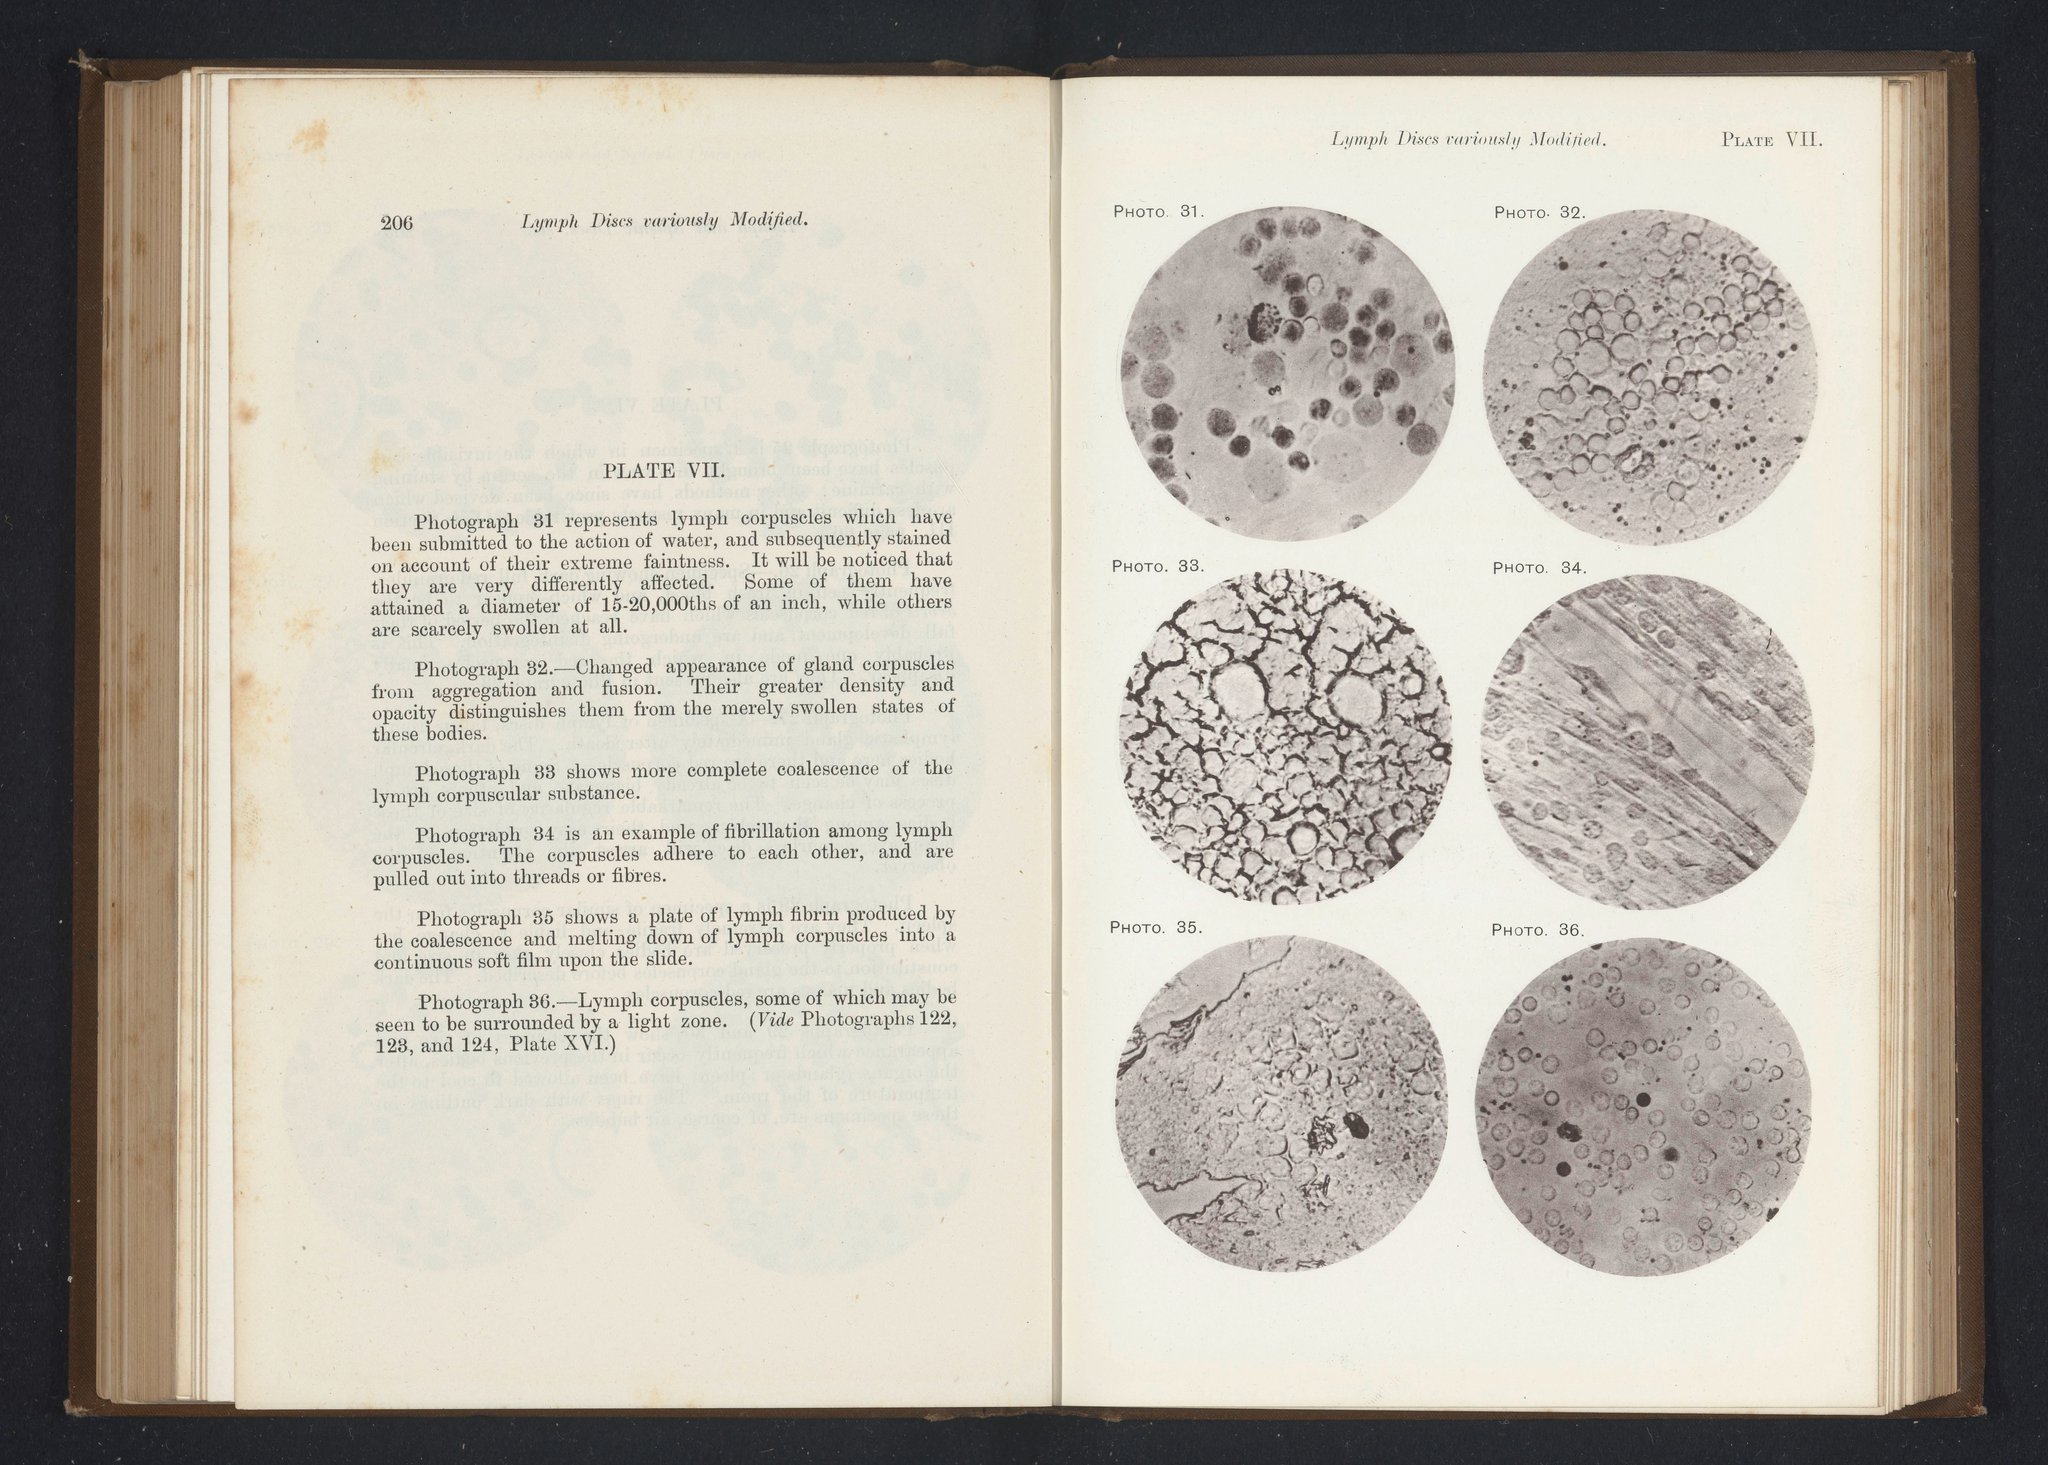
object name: photomechanical print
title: Zes vergrotingen van lymfocyten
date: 1872-1882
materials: paper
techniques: photograph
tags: blood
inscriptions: number: ‘Pl. VII.’, number: ‘Photo. 31. (...) Photo. 36.’